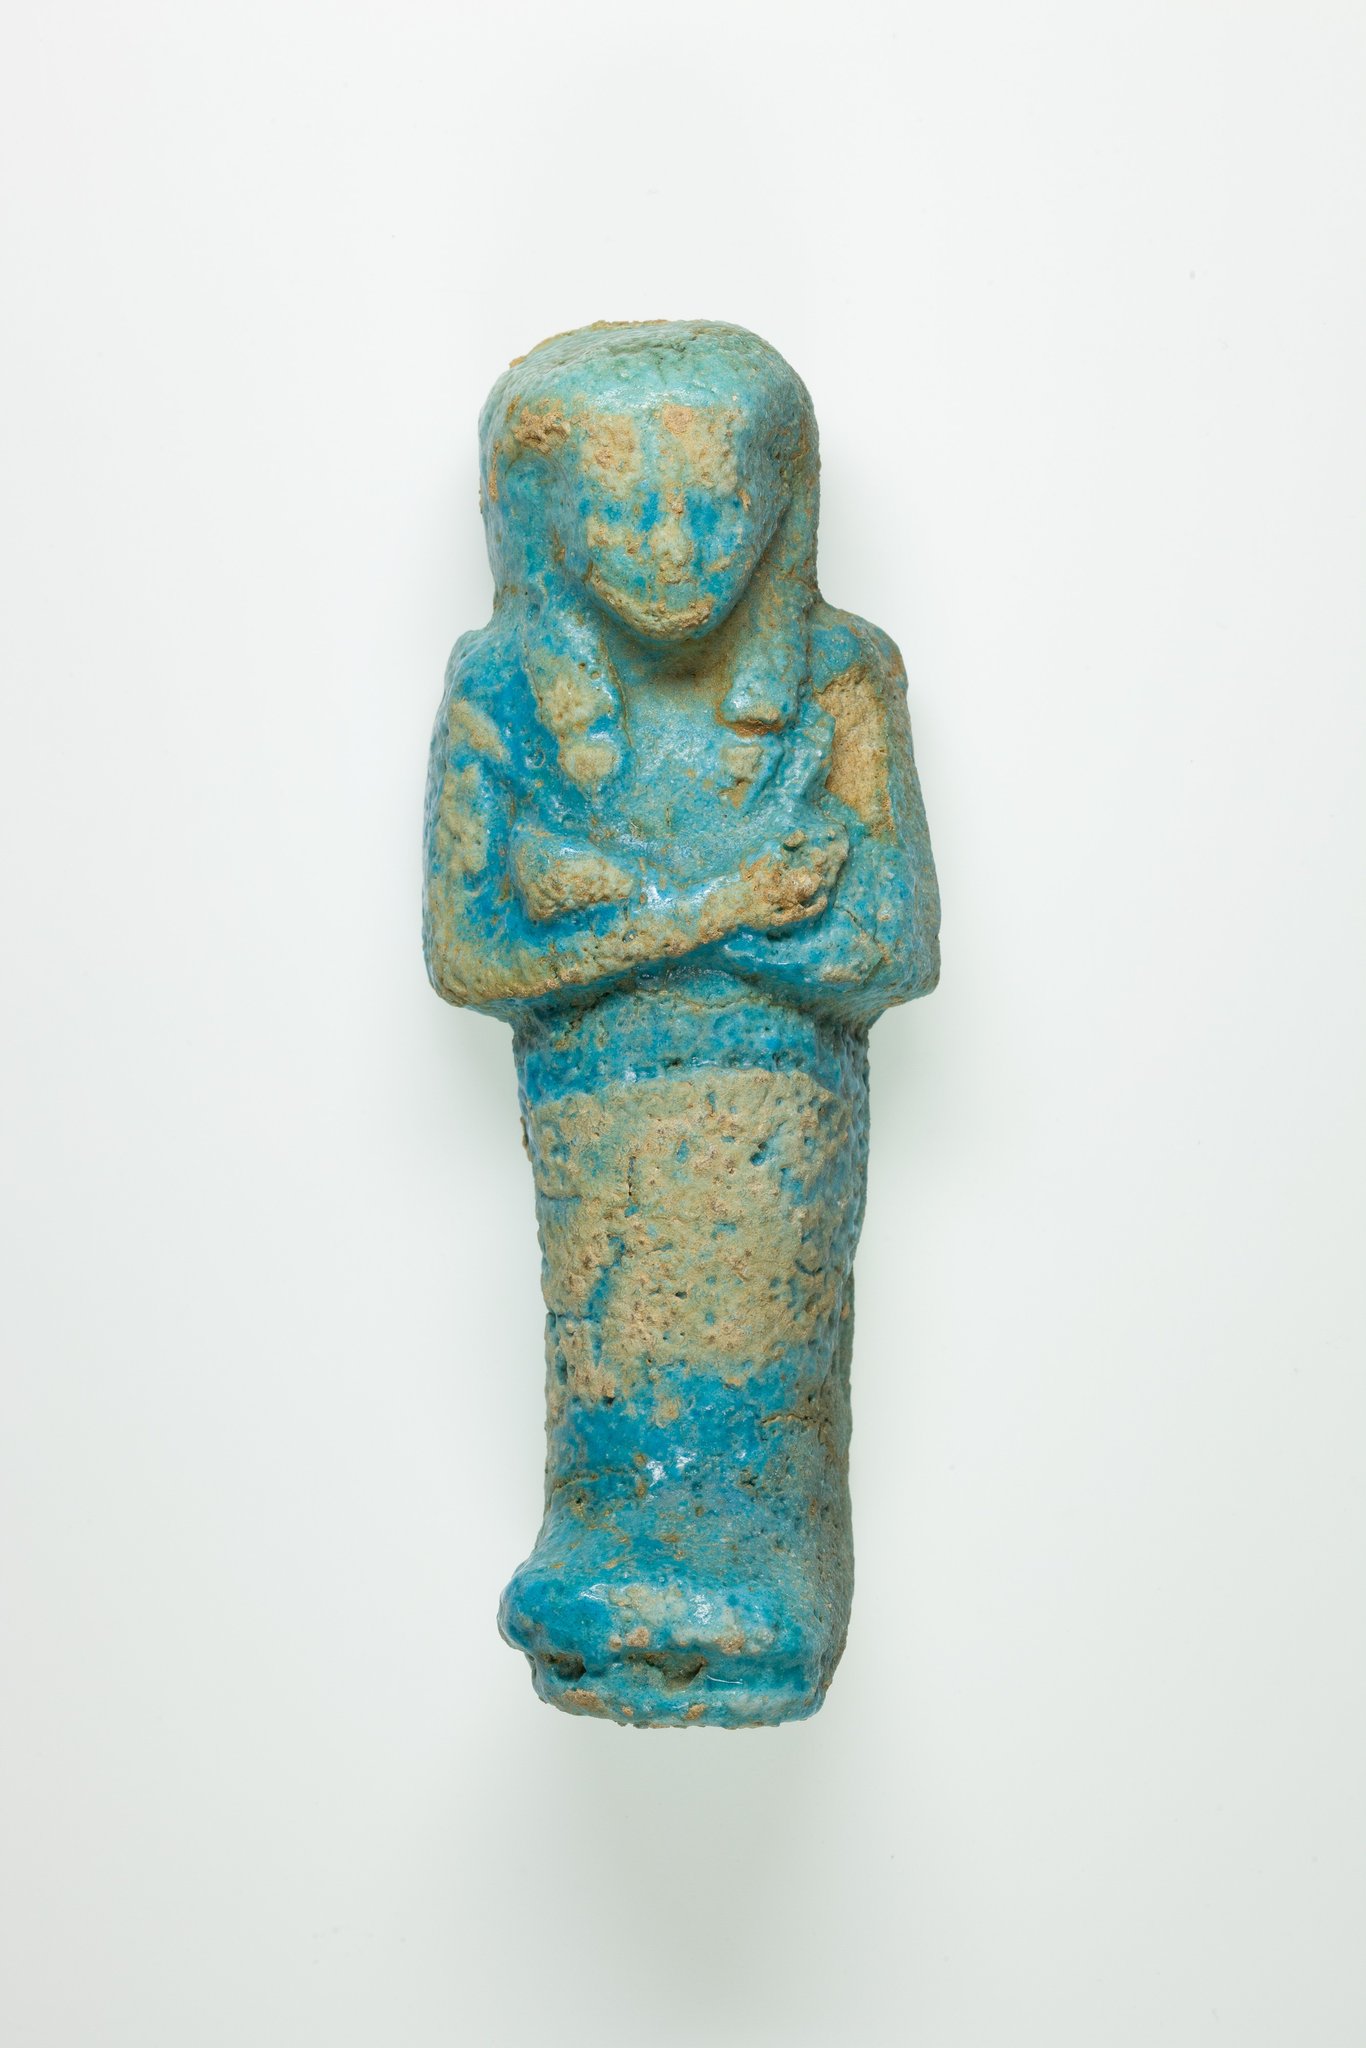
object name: worker shabti, henettawy c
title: Worker Shabti of Henettawy (C), Daughter of Isetemkheb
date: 990-970 BCE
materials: faience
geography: egypt